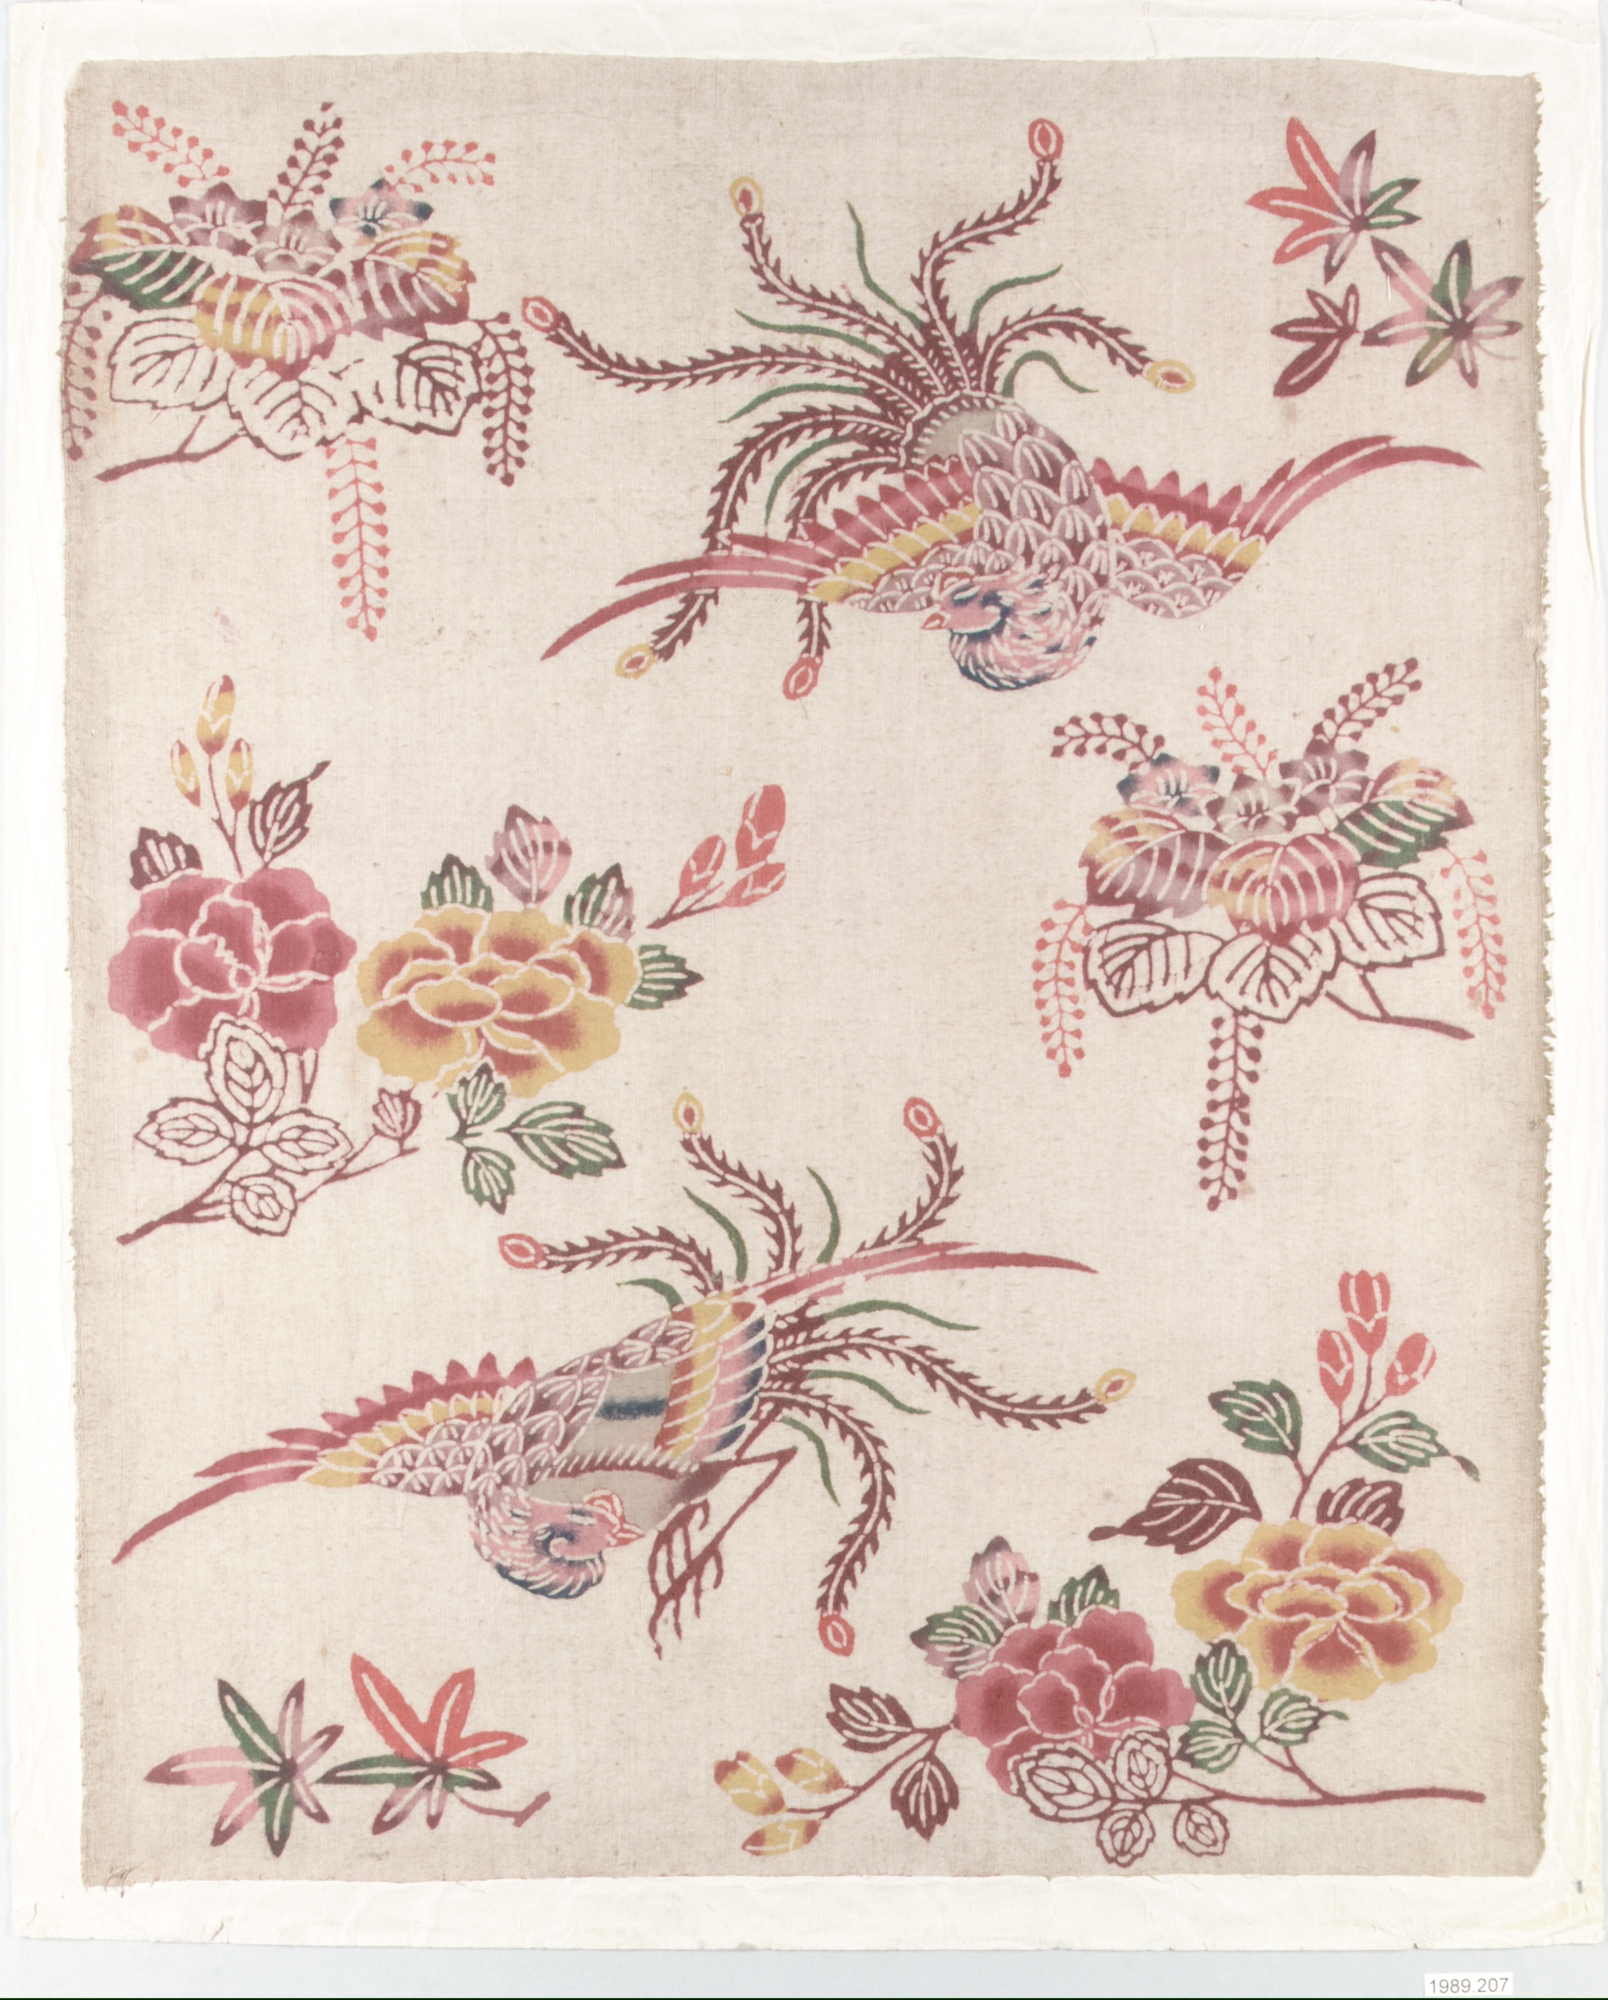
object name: bingata panel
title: Bingata Panel with Hō-ō Birds and Flowers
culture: japanese or ryukyuan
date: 1701-1800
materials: cotton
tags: birds,flowers,leaves